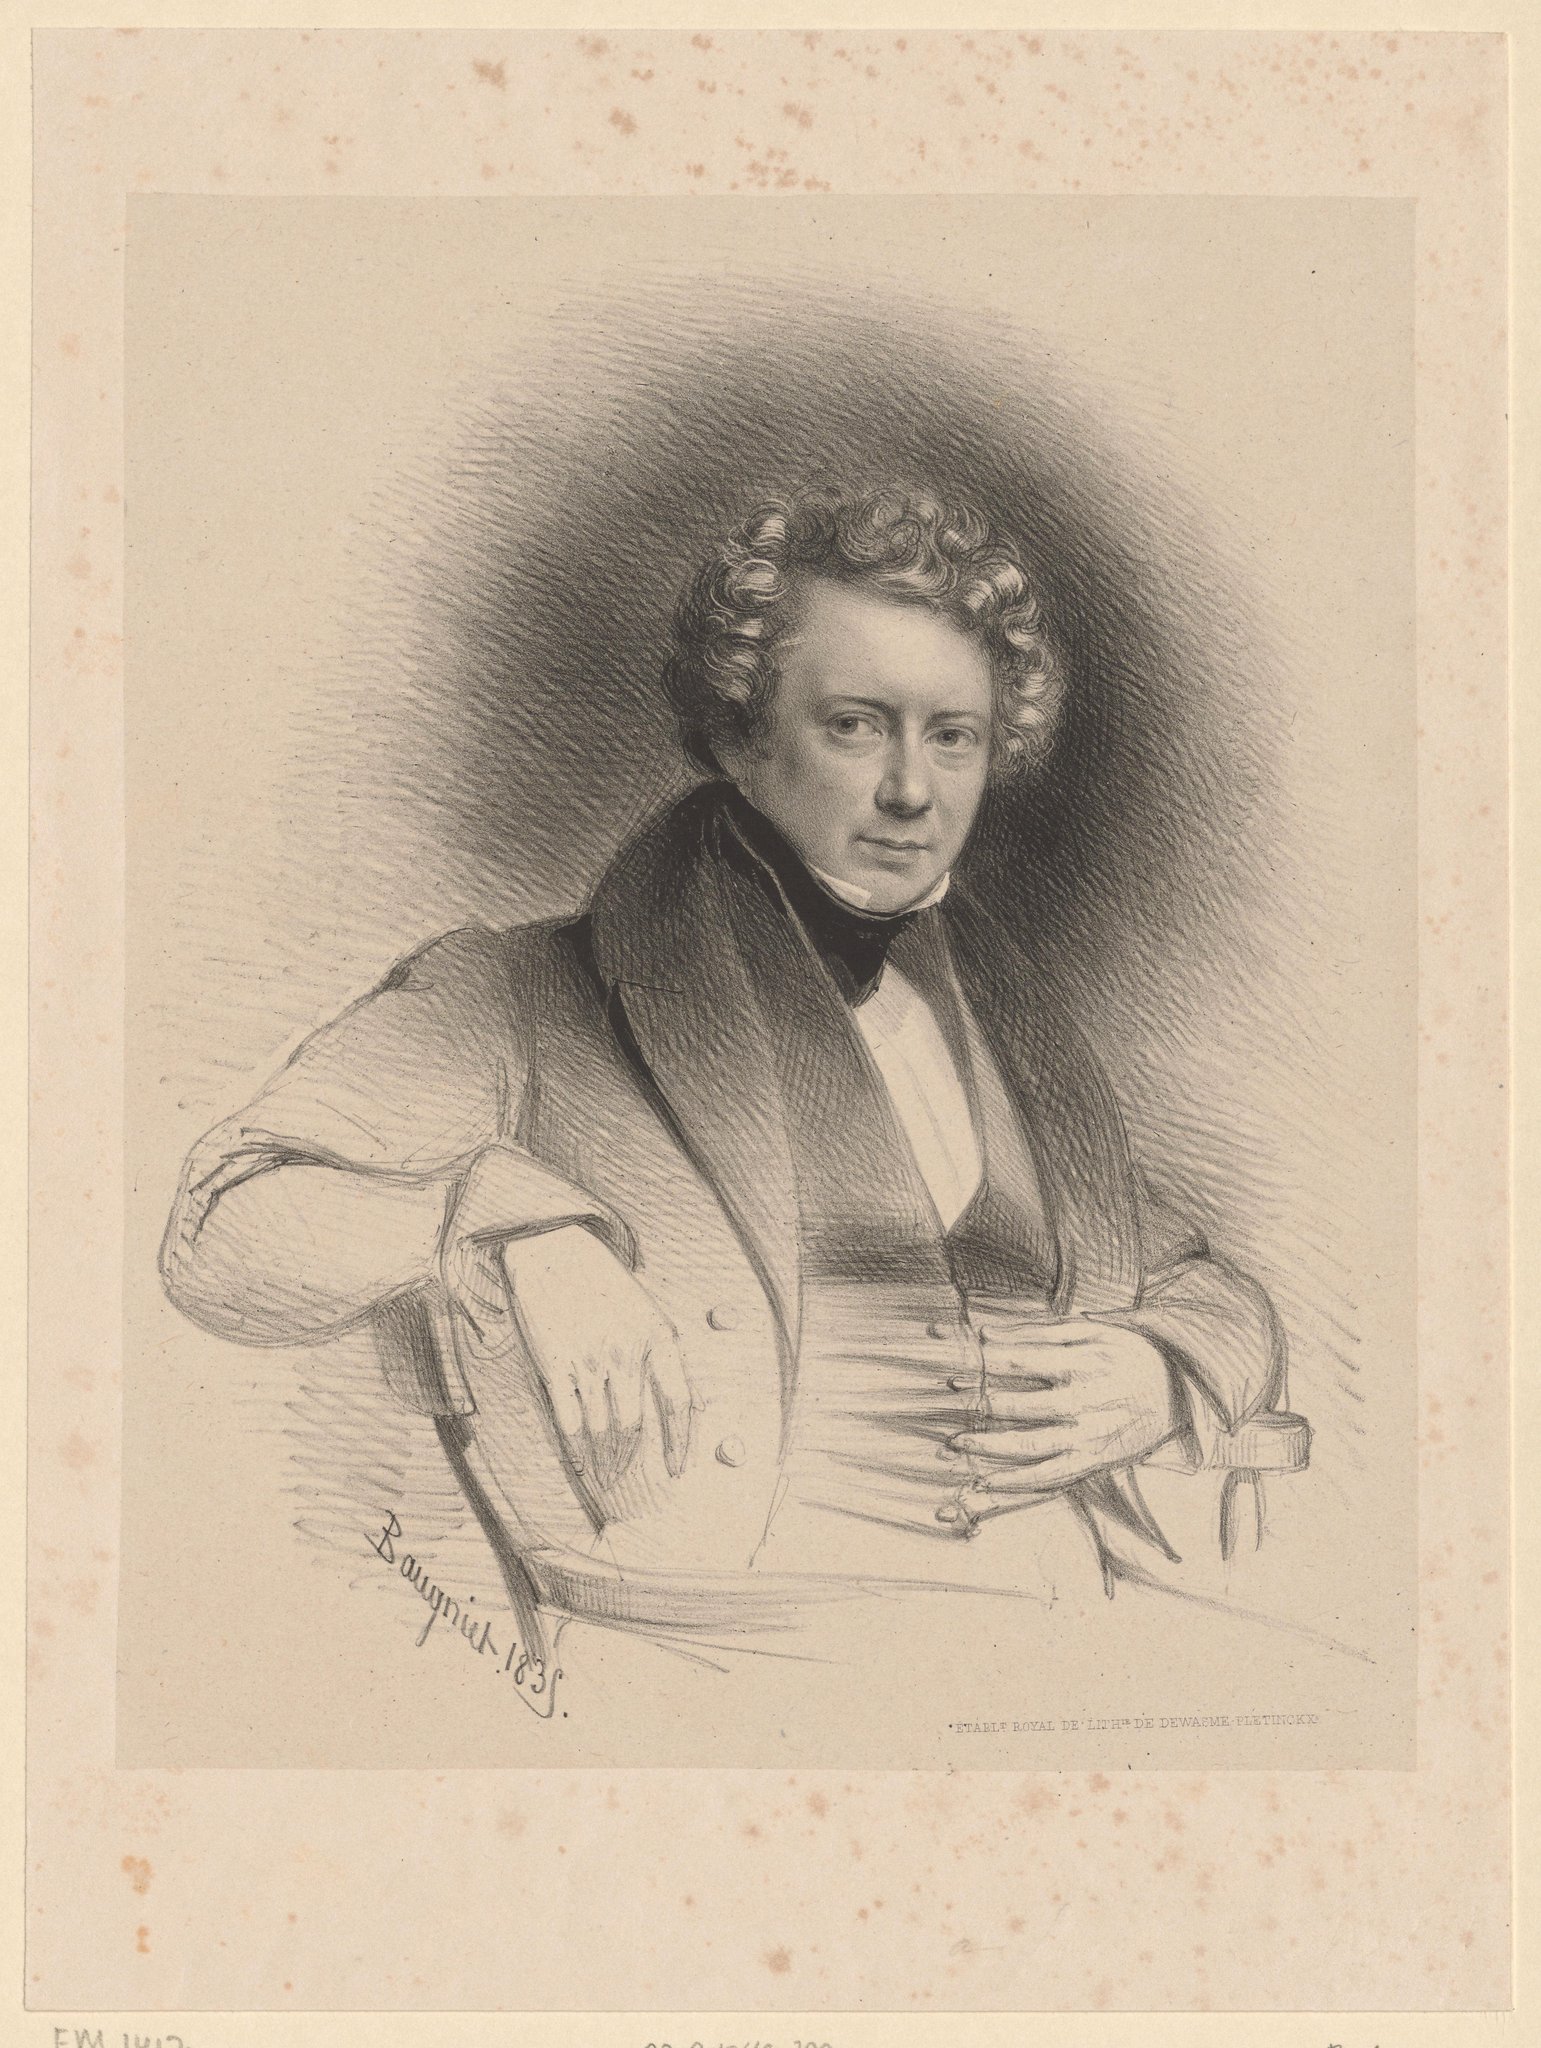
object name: print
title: Portret van Jacob Joseph Eeckhout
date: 1839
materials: paper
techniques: lithograph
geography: brussels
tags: antwerp, paris, print maker, draughtsman, jacob joseph eeckhout, historical persons, portrait, self-portrait of artist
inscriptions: collector's mark: Lugt 2760, collector's mark: Lugt 2228